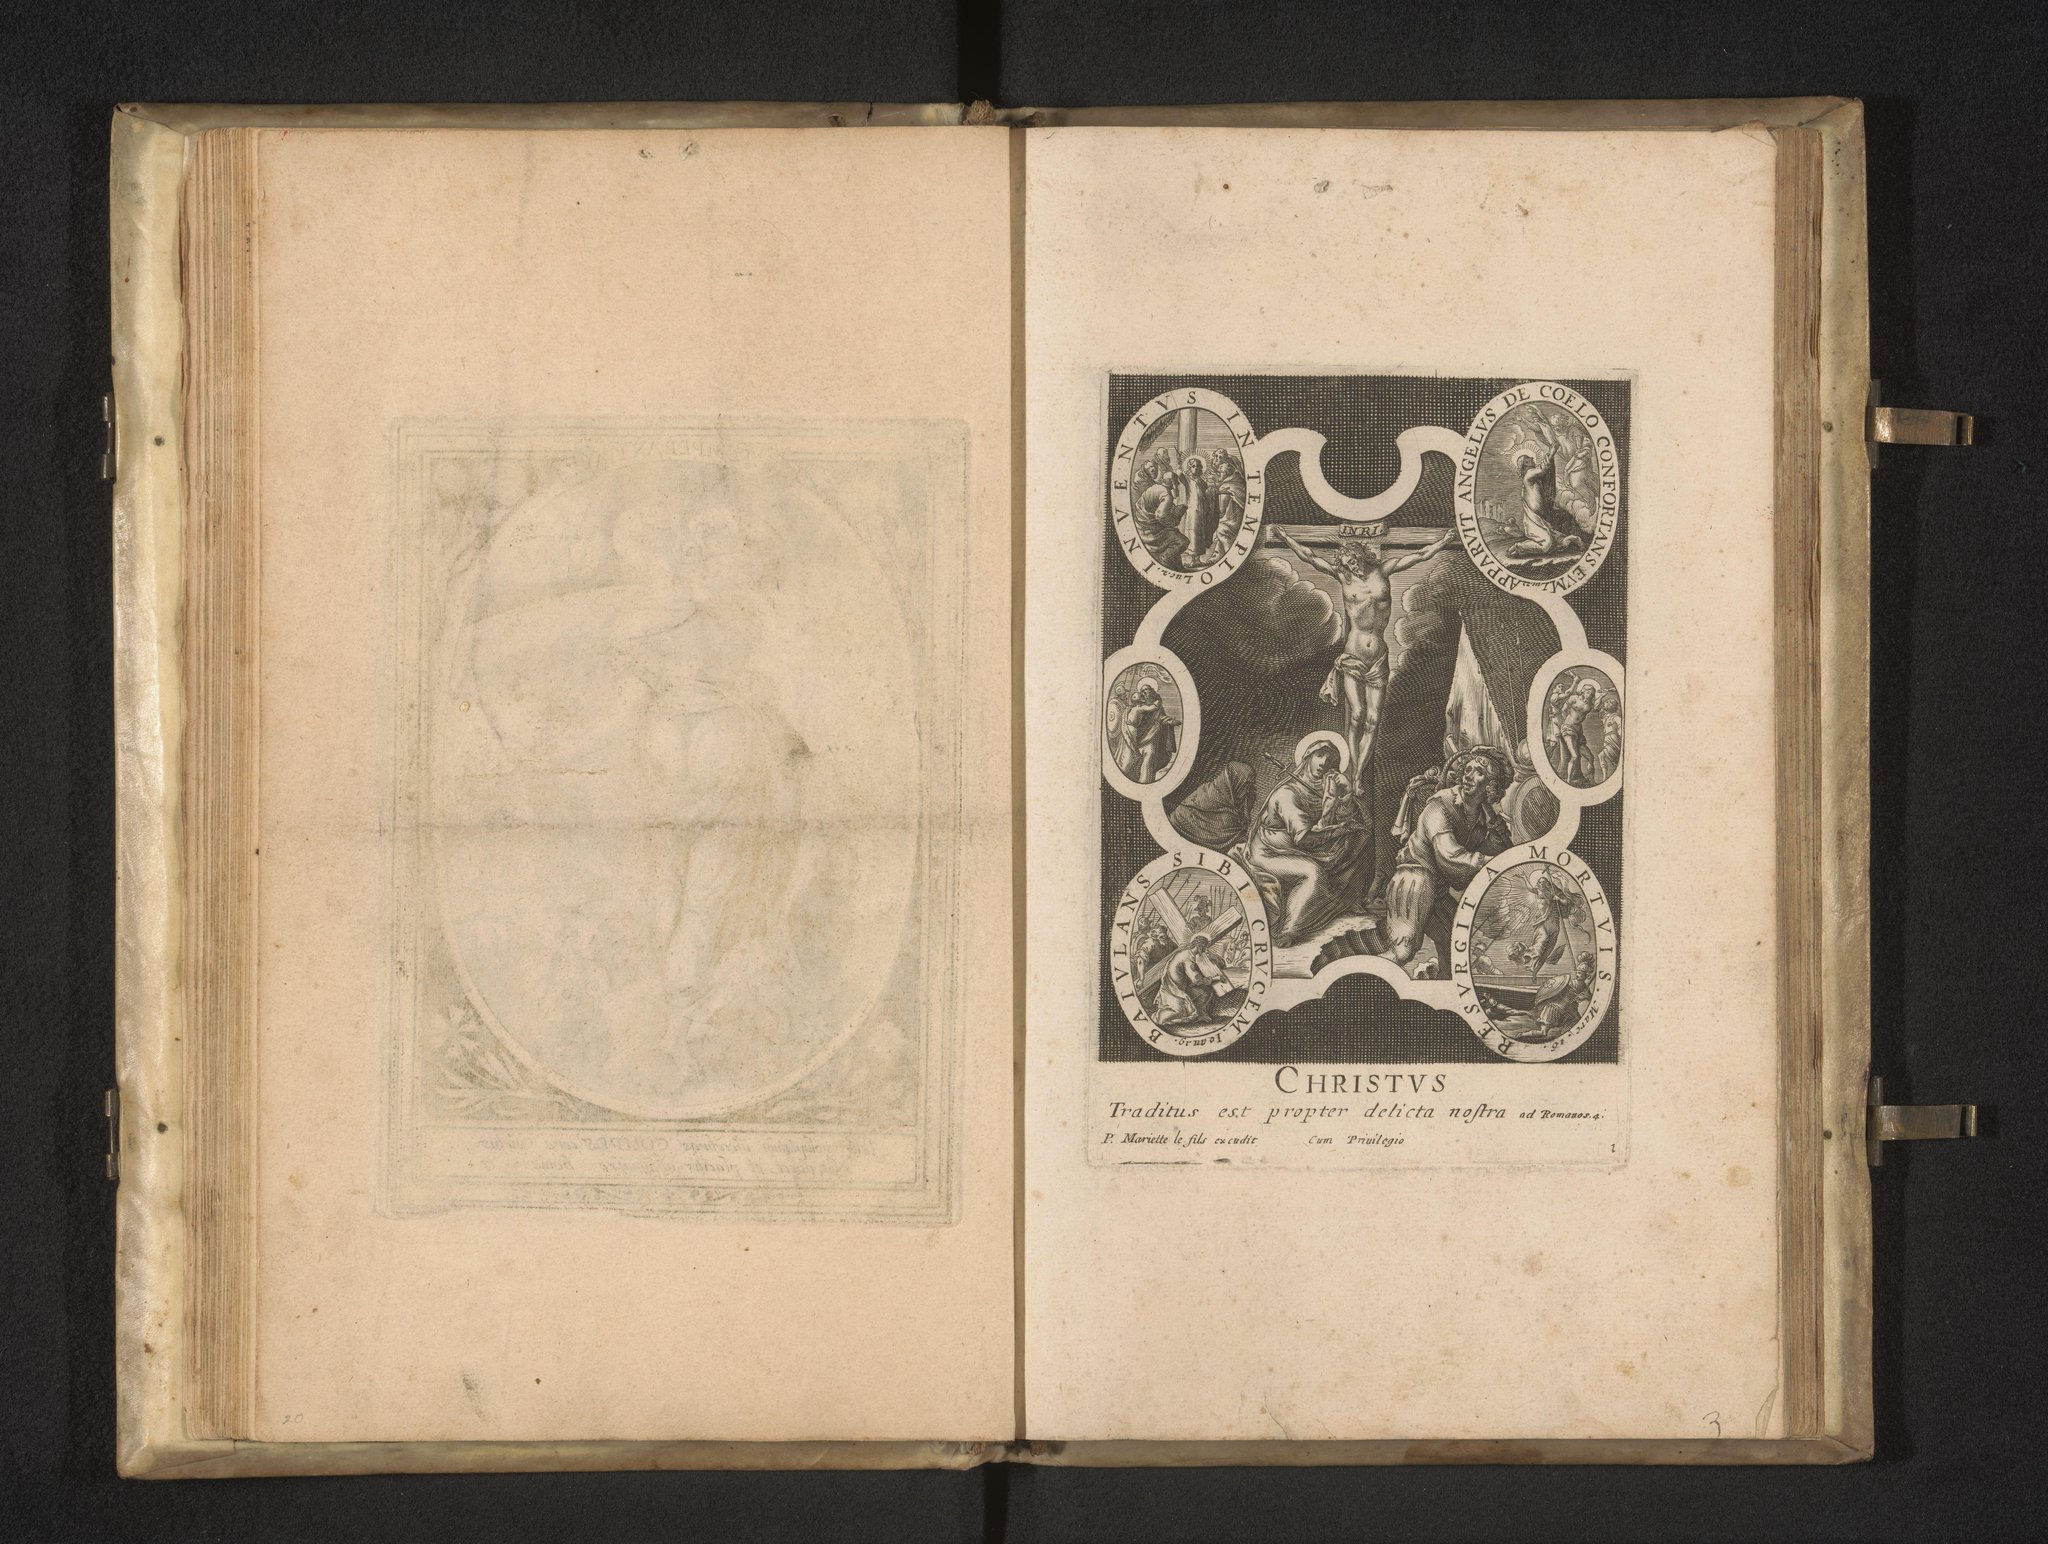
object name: print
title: Christus aan het kruis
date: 1654-1716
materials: paper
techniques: engraving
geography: paris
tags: crucified christ, with particular persons under the cross, the (seven) sorrows of mary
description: Christus aan het kruis, in een kader van zes kleine scènes uit de Passie van Christus. Onderdeel van een serie van twaalf voorstellingen van het martelaarschap van de apostelen. Onderdeel van een album met voornamelijk christelijke voorstellingen.